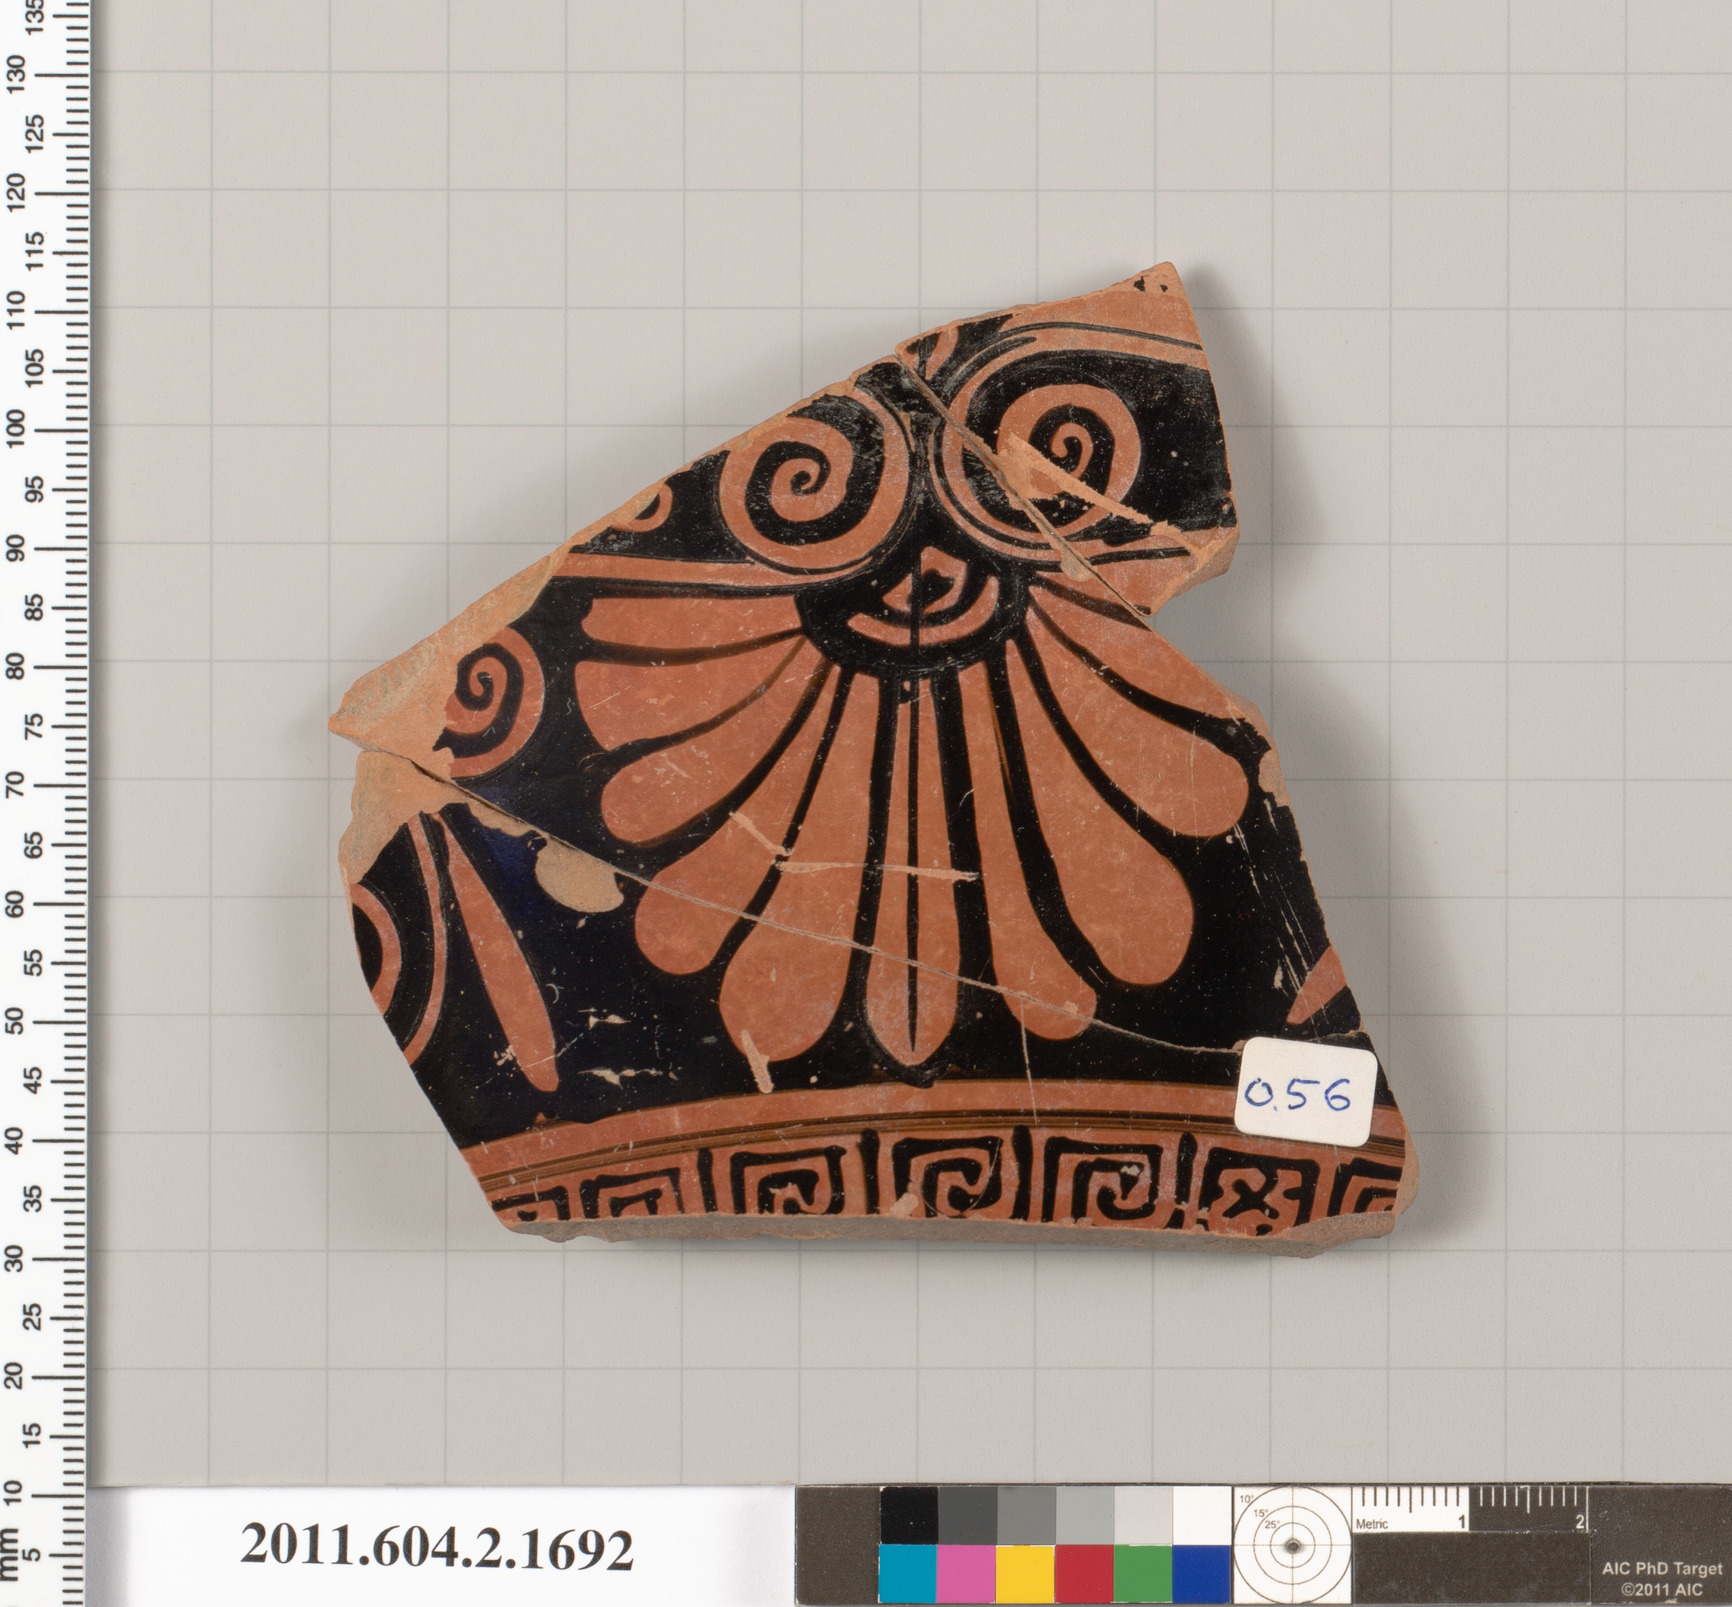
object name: skyphos fragment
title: Terracotta fragment of a skyphos (deep drinking cup)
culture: greek, attic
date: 450-440 BCE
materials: terracotta